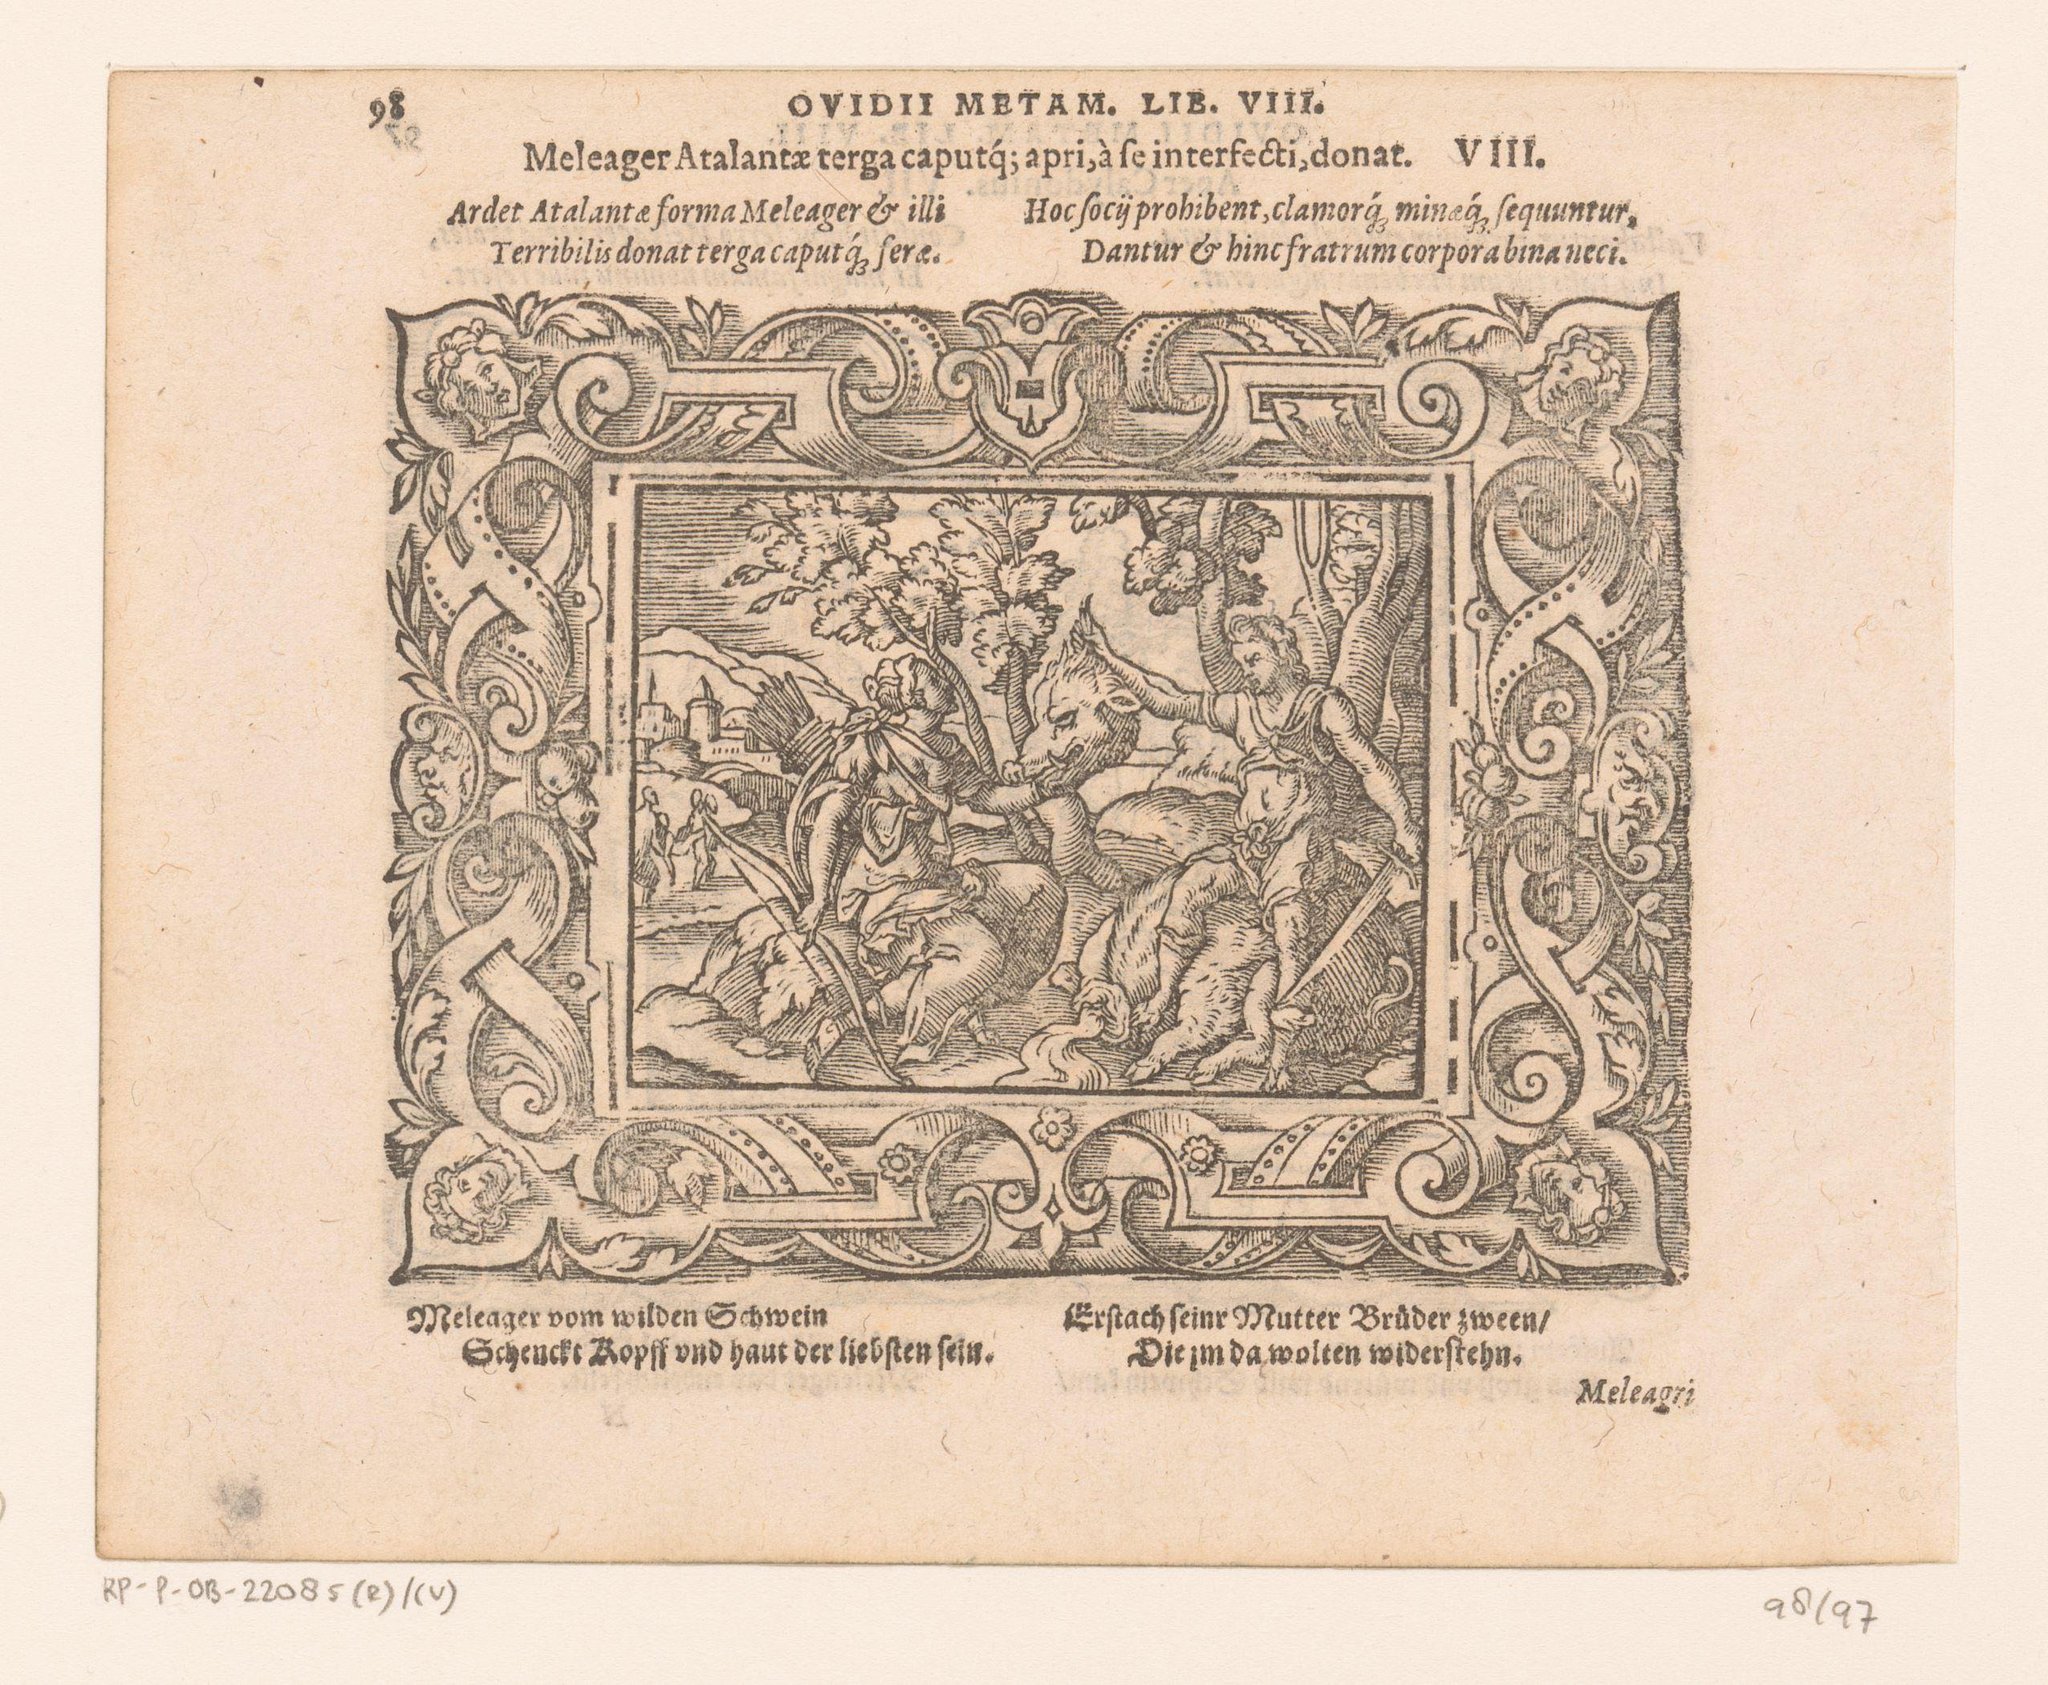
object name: book illustration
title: Meleager Atalantae terga caputq; apri, à se interfecti, donat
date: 1569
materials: paper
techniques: letterpress printing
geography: nuremberg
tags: scrollwork, strapwork ~ ornament, meleager gives the head of the boar to atalanta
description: Illustratie bij de Metamorfosen van Ovidius, afkomstig uit de publicatie: Posthius, Johannes. Tetrasticha in Ovidii metam. Frankfurt am Main: Georg Rab en Sigmund Feyerabend en erven Weigand Han, 1569. De voorstellingen en ornamentranden van deze boekillustraties zijn van twee aparte blokken gedrukt. Beide werden afzonderlijk van elkaar ook gebruikt voor andere publicaties, en de ornamentranden werden eveneens binnen deze publicatie meerdere keren gebruikt.